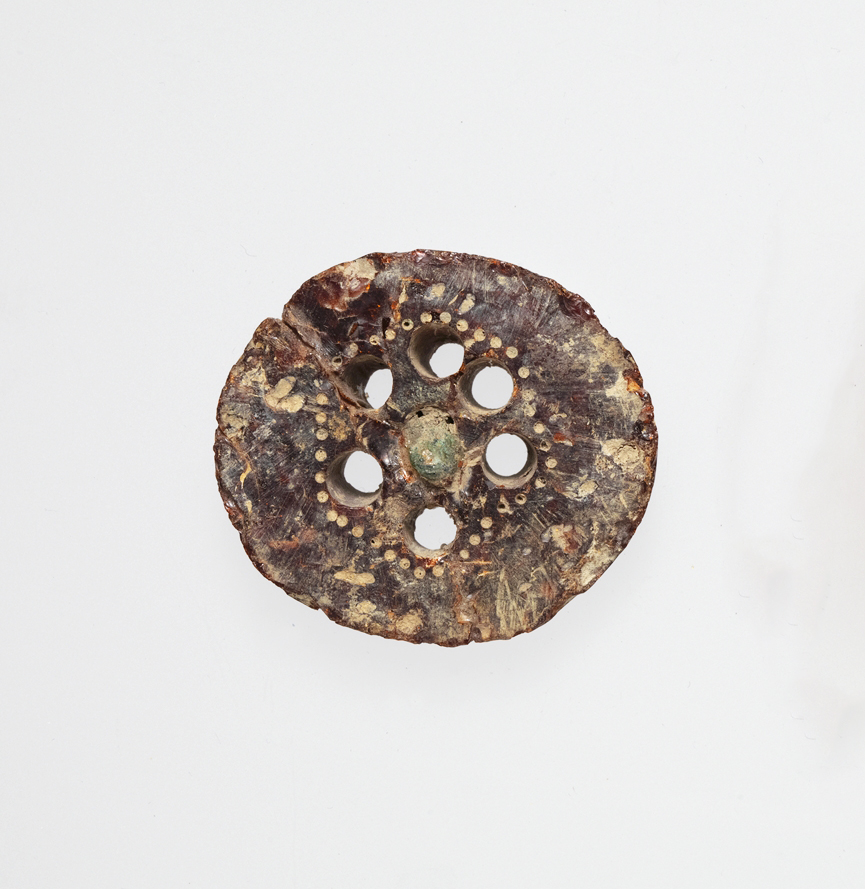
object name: fibula, fragment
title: Segment from a bronze fibula (safety pin)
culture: etruscan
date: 700-501 BCE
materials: amber, bronze